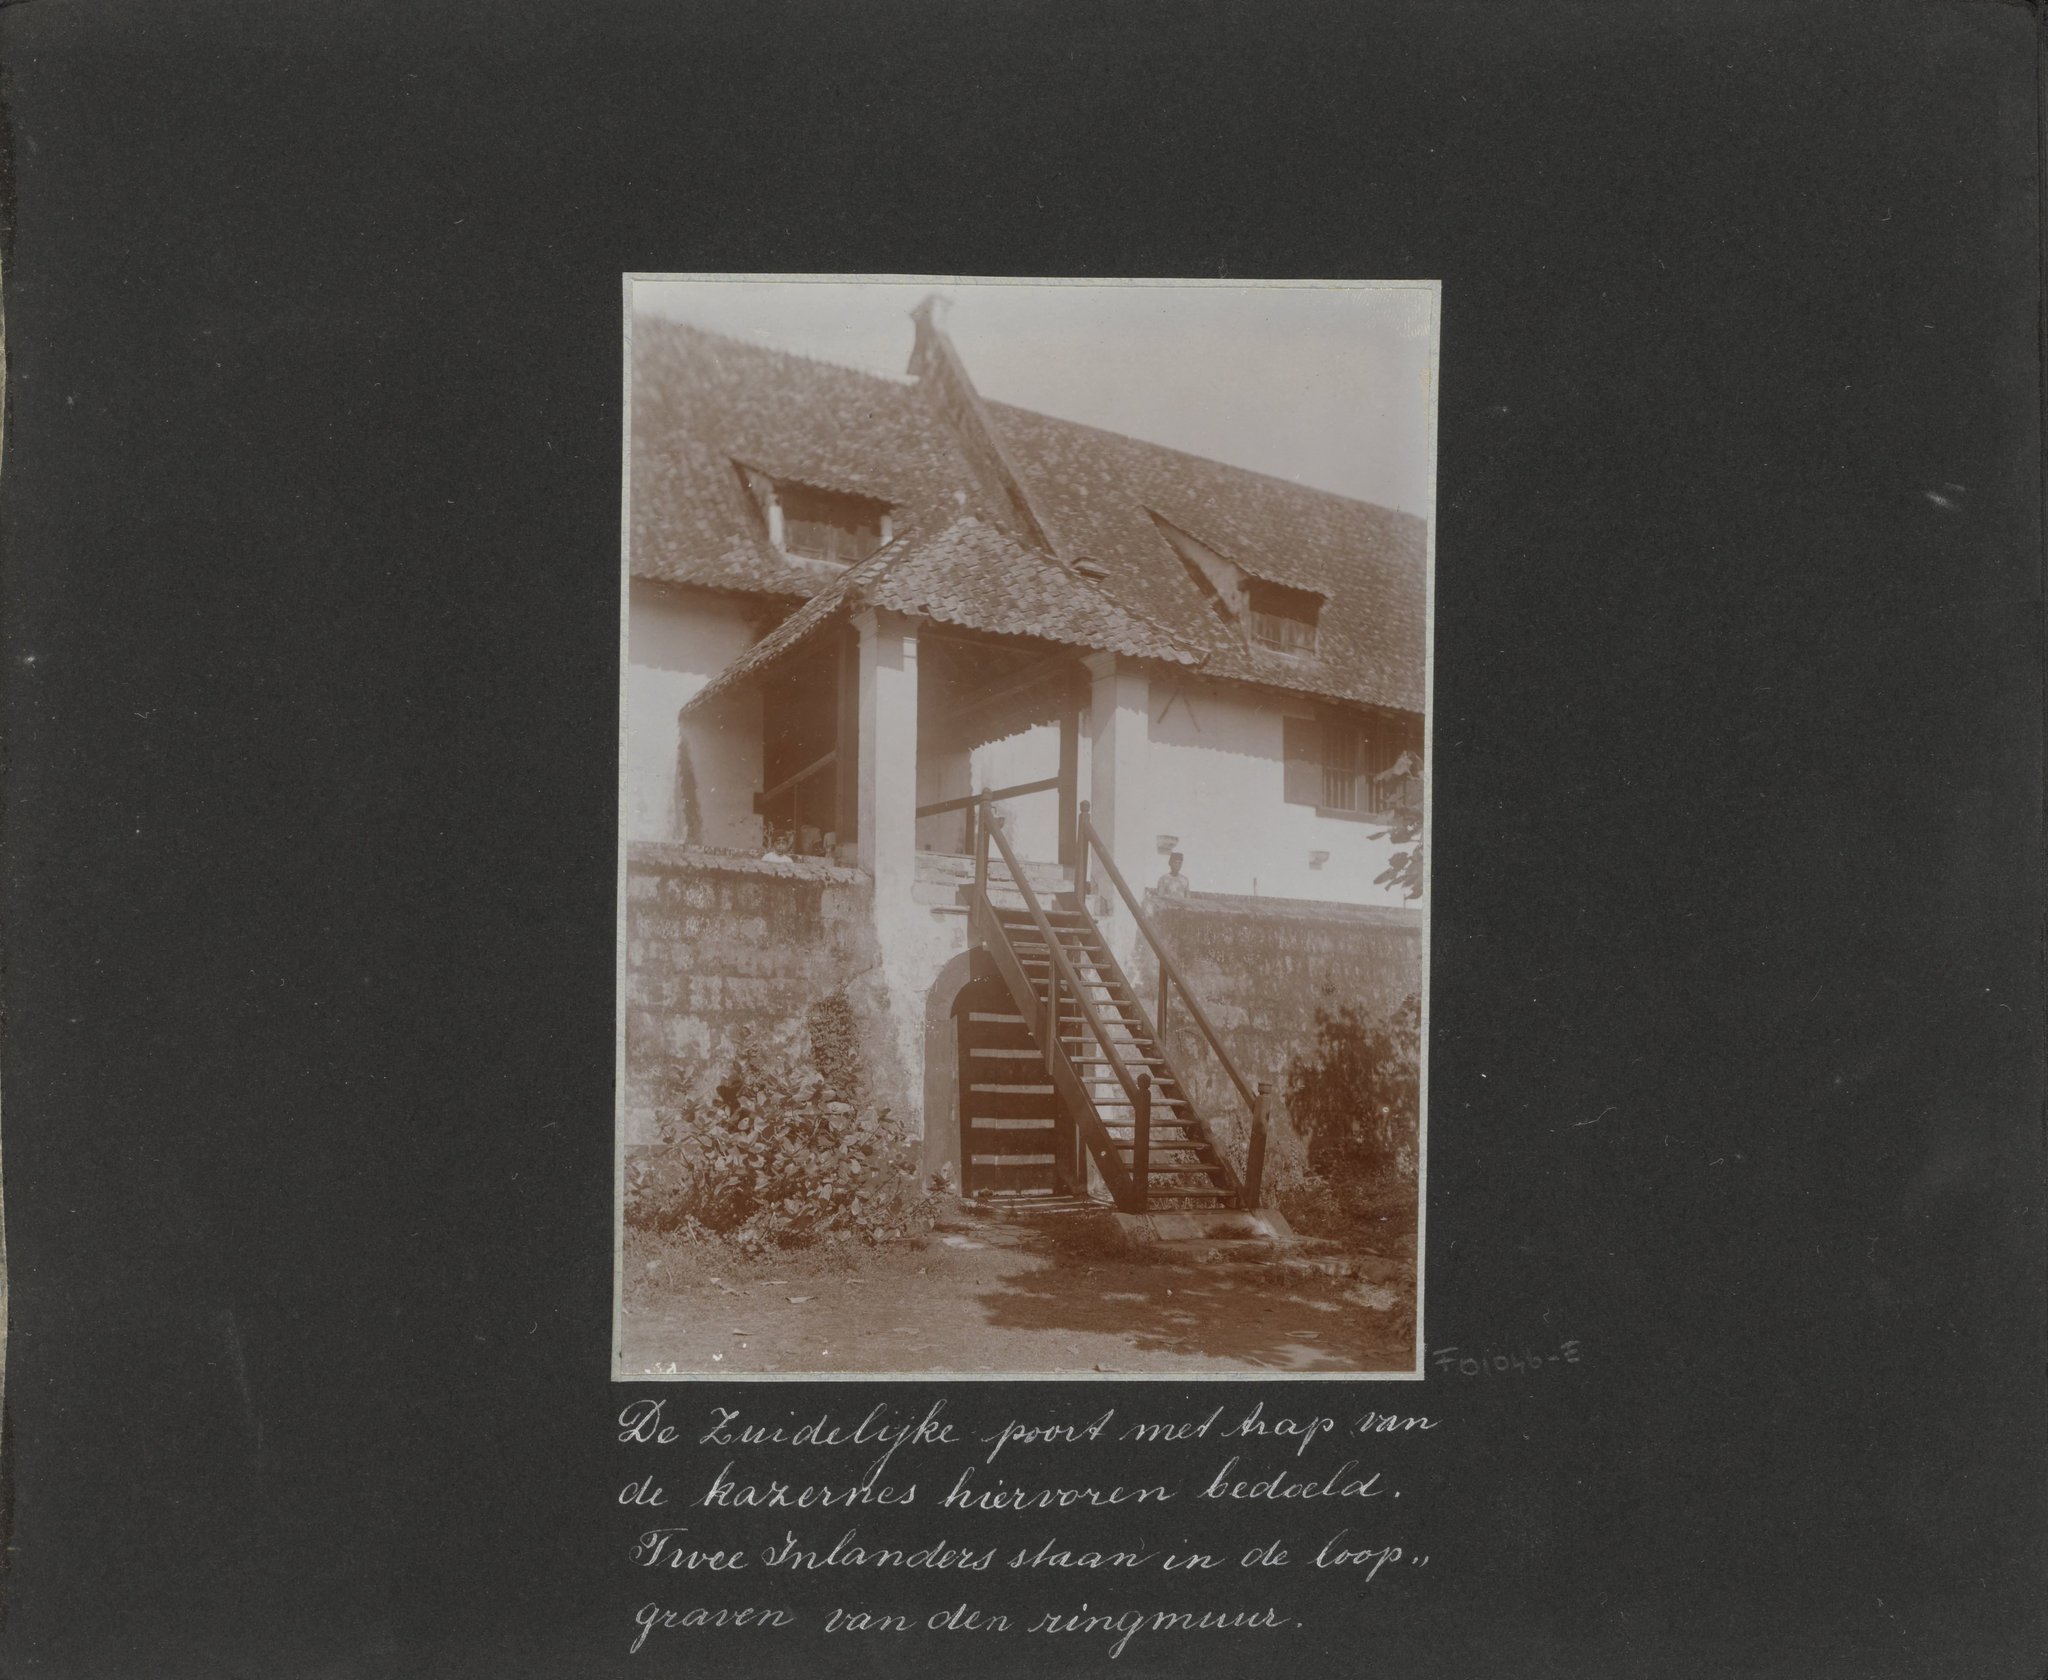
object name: album leaf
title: De Zuidelijke poort met trap van de kazernes hiervoren bedoeld. Twee inlanders staan in de loopgraven van den ringmuur.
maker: Anonymous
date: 1920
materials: paper, photographic support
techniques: gelatin silver print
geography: batavia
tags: gate, entrance, barracks, dutch east indies, the, batavia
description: Onderdeel van Reisalbum met foto's van Batavia.